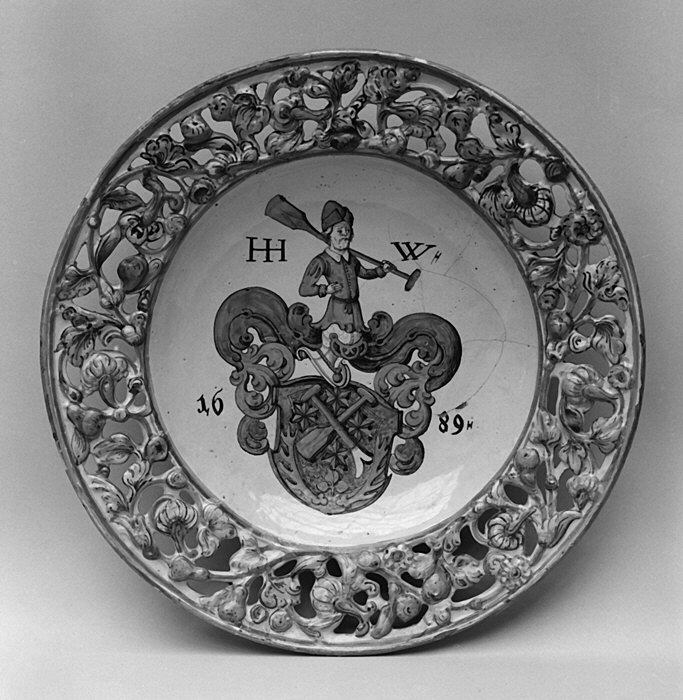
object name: dish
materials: earthenware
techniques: glazing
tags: men,flowers,coat of arms